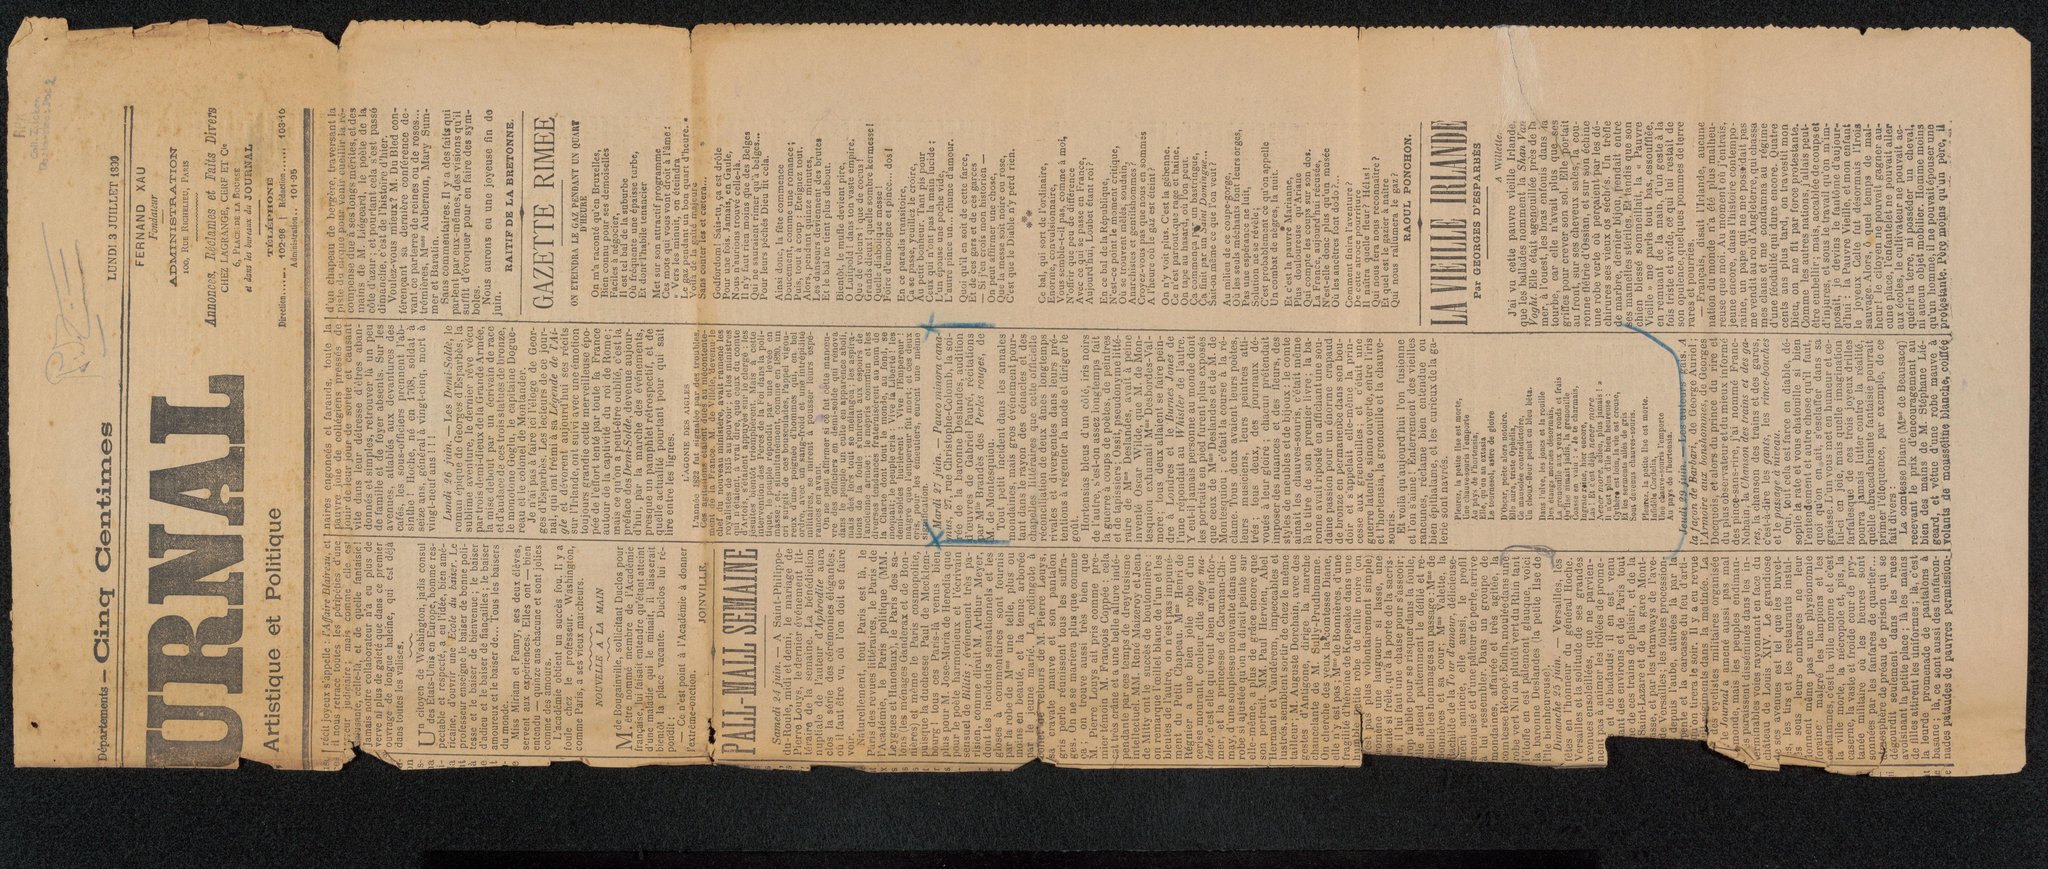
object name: newspaper clipping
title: Krantenknipsel uit archief Philip Zilcken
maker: Anonymous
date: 1899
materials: paper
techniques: printing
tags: baronne madeleine deslandes, painter, draughtsman, philip zilcken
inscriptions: collector's mark: ‘RPK’